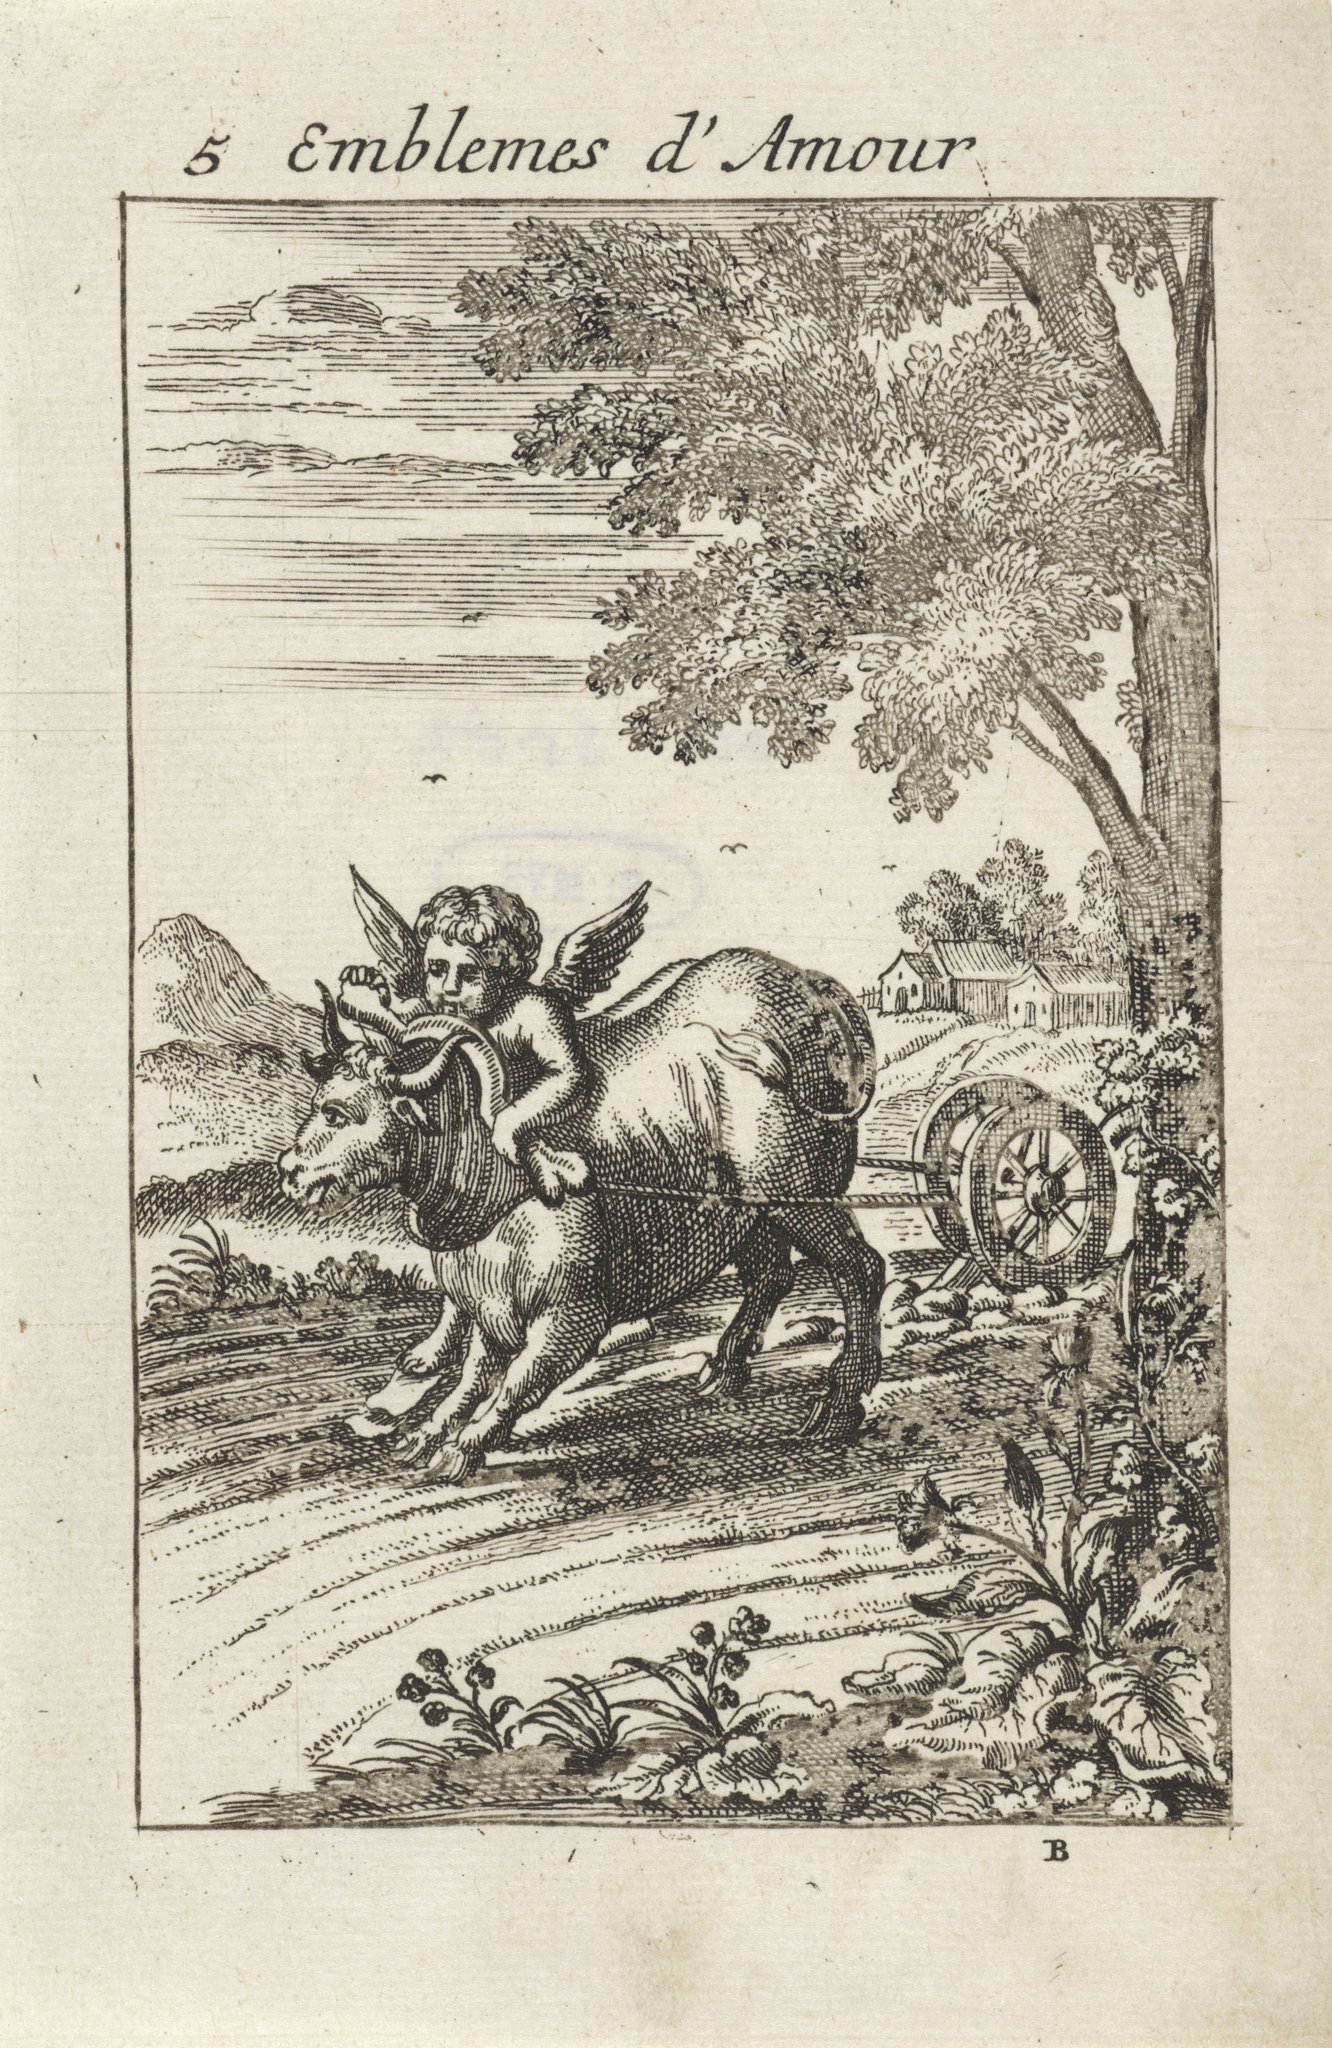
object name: print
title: Amor doet een jonge stier een juk om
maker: jan van vianen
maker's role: print maker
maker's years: 1660-1726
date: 1686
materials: paper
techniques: etching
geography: northern netherlands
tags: bull, (story of) cupid, amor (eros), yoke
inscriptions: collector's mark: Lugt 2228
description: Amor doet een jonge stier een juk om. De liefde zal een jonge persoon zwaar vallen, maar zal later gewillig gedragen worden. Vijfde embleem uit Emblemata Amatoria.